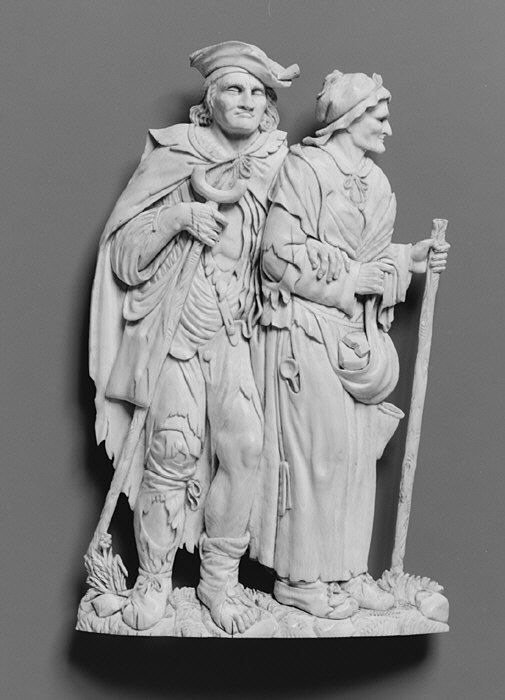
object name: relief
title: Beggar couple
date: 1767-1800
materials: ivory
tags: couples,men,women